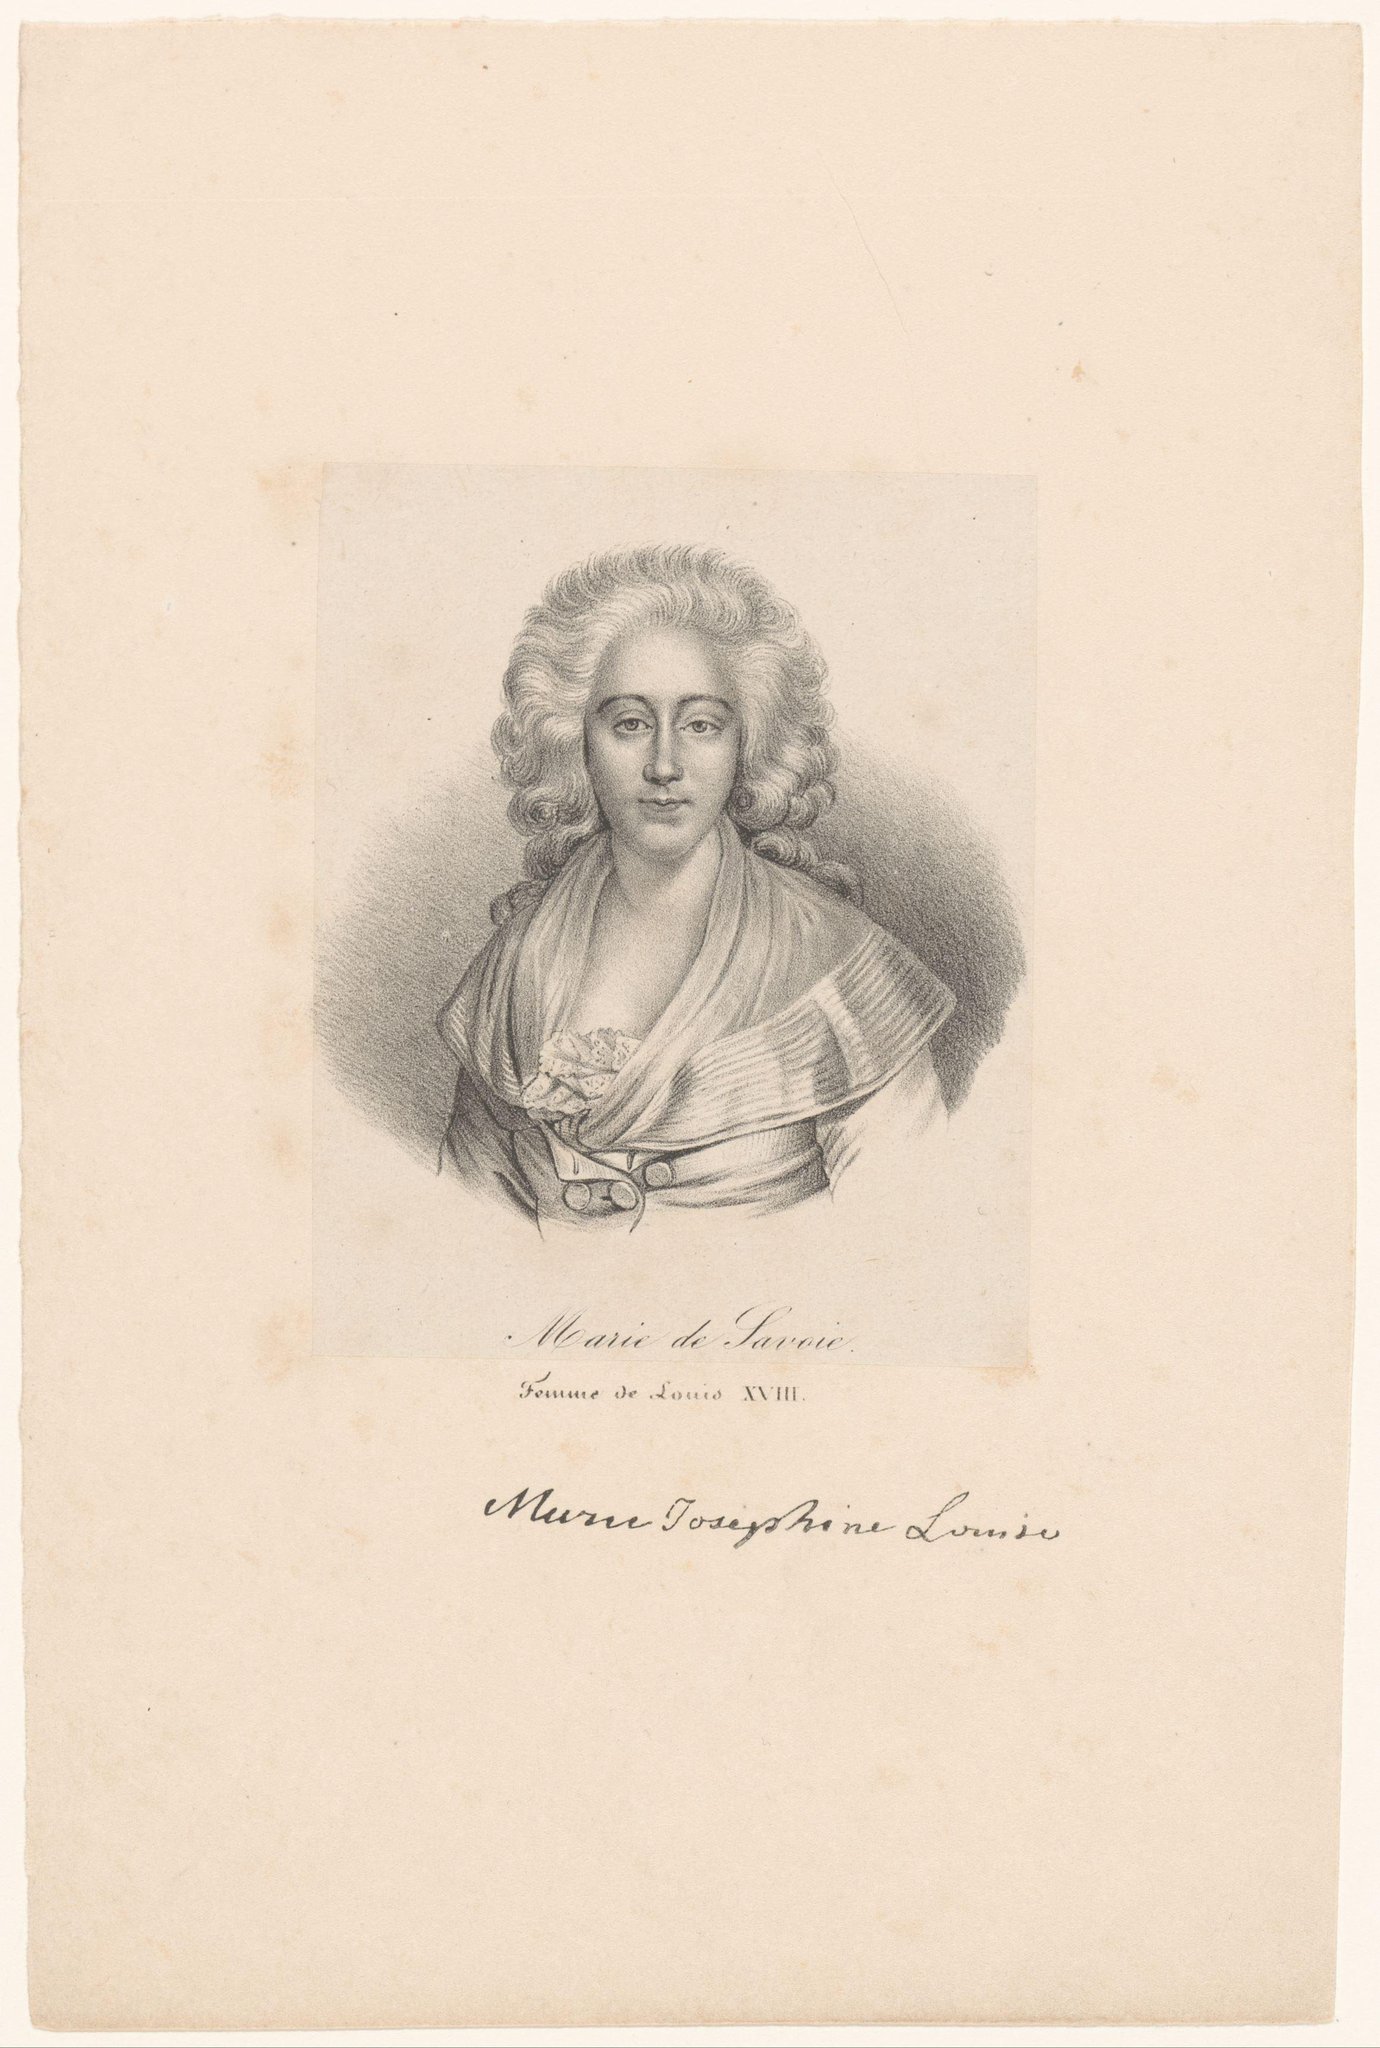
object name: print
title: Portret van Maria Josephine van Savoye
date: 1818-1842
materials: paper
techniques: lithograph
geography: paris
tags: england, historical persons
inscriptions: collector's mark: Lugt 2228a